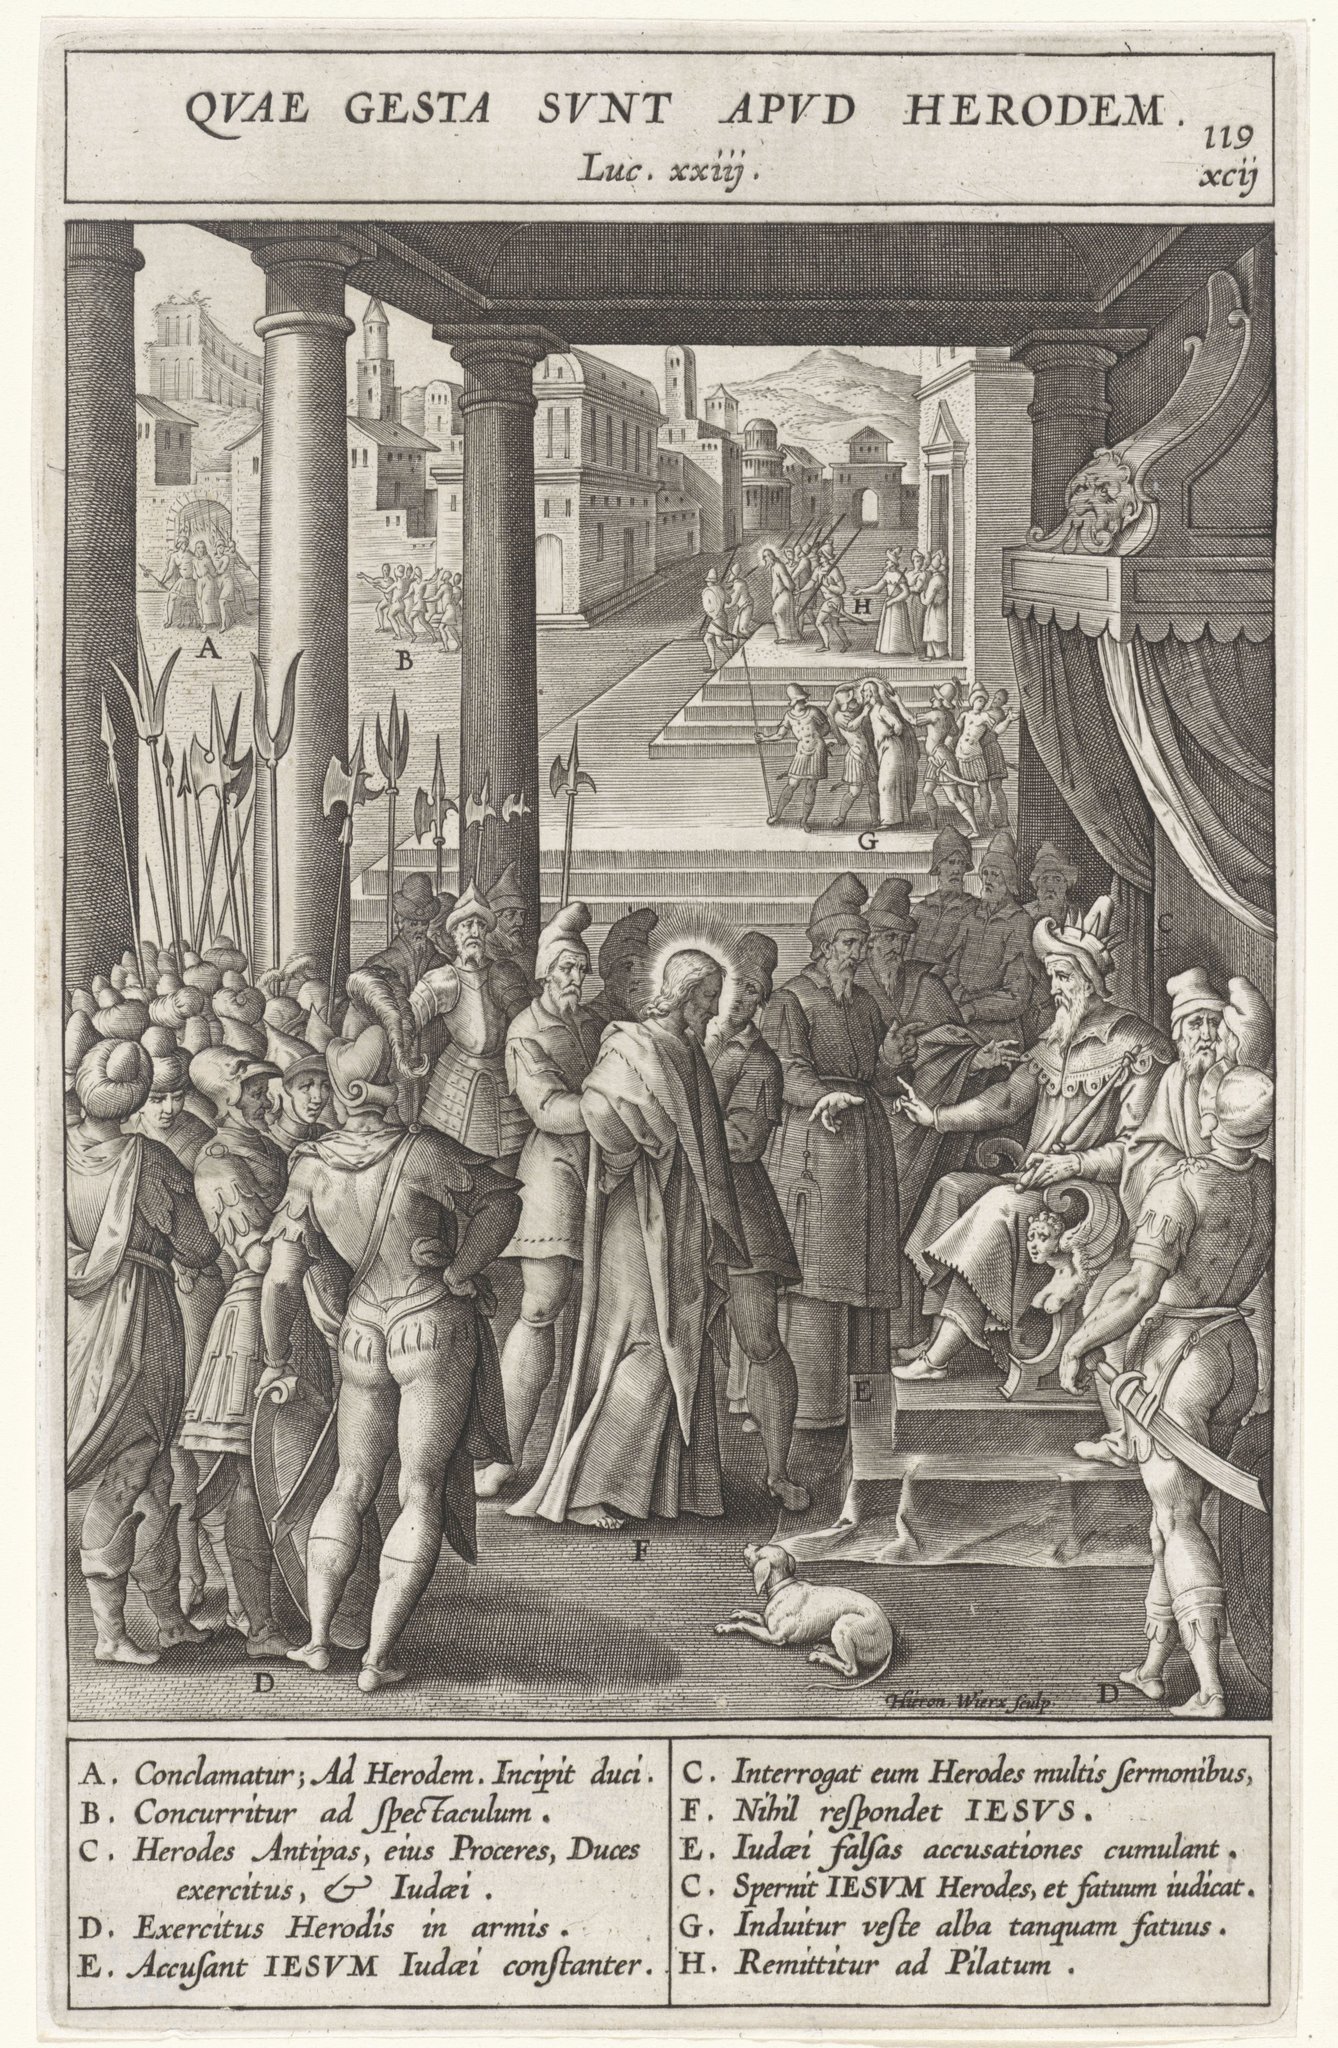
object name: print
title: Qvae Gesta Svnt Apvd Herodem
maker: hieronymus wierix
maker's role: draughtsman, print maker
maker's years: 1553-1619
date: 1593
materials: paper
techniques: engraving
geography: antwerp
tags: christ before king herod; sometimes a gorgeous robe is brought (luke 23:8-11)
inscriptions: collector's mark: Lugt 2165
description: Koning Herodes ondervraagt Christus, maar die antwoordt hem niet. Hierop bespotten Herodes en zijn soldaten Christus. Bij verschillende elementen uit de voorstelling staan letters die corresponderen met de legenda in de marge.